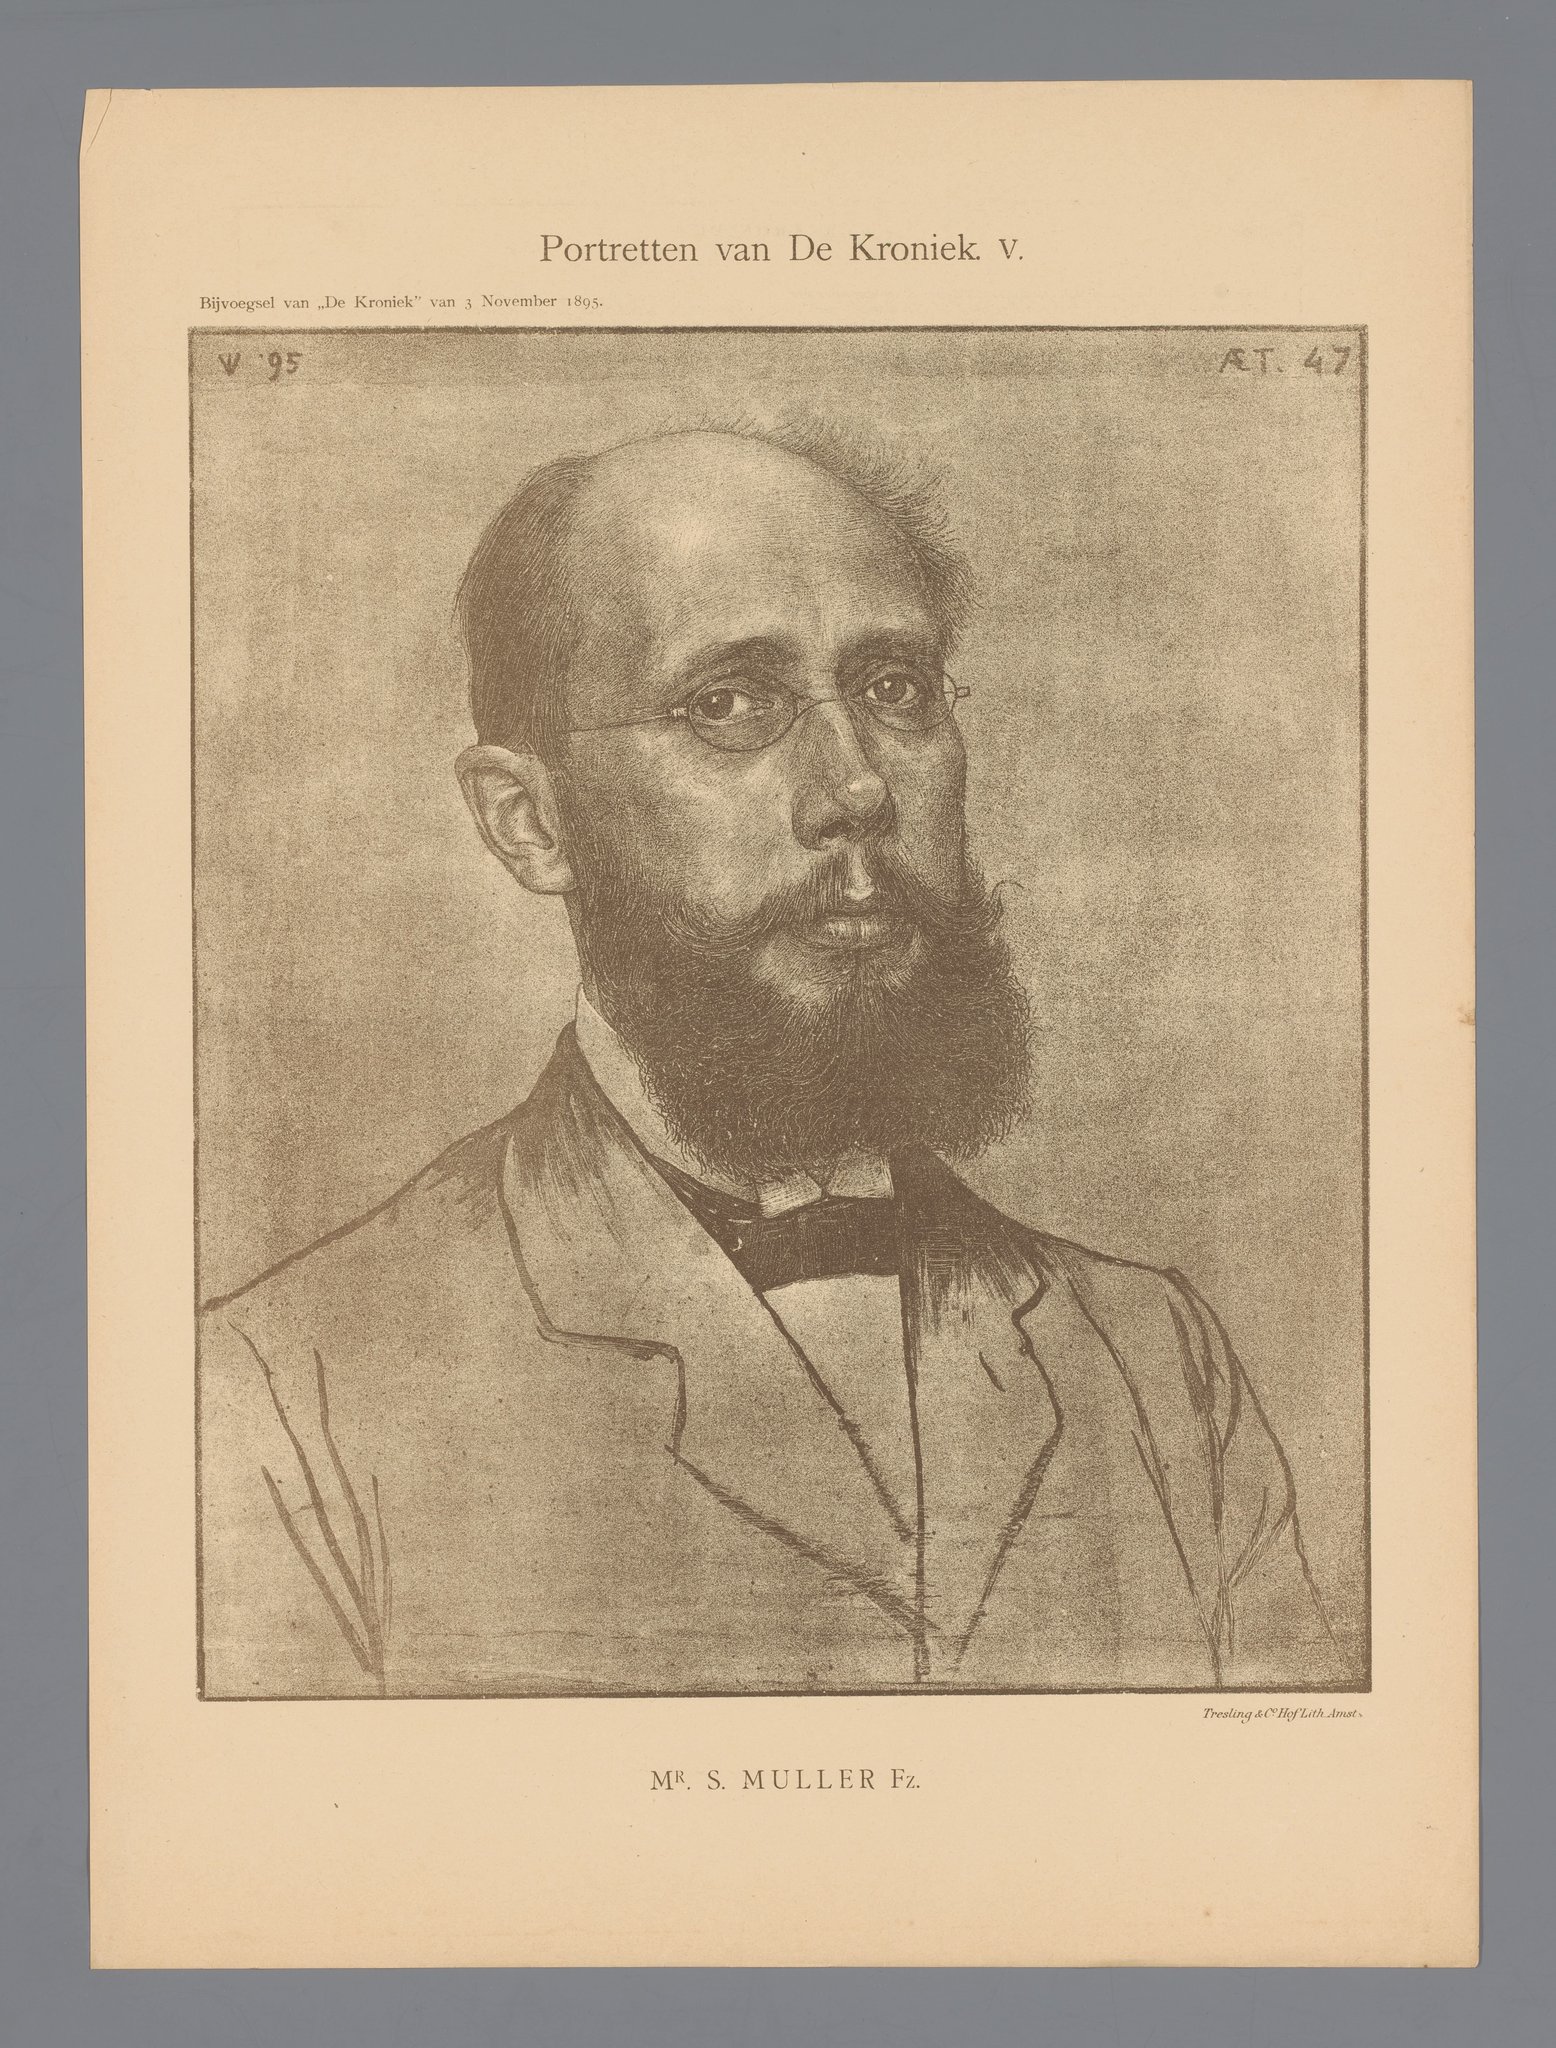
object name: print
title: Mr. S. Muller Fz.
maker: jan veth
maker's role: designer, draughtsman, painter, print maker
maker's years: 1864-1925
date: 1895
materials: paper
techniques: lithograph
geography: amsterdam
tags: samuel muller (1848-1922), adult man, historical persons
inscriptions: date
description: Prent uit het bijvoegsel van: De Kroniek 1 (1895), 3 november 1895.